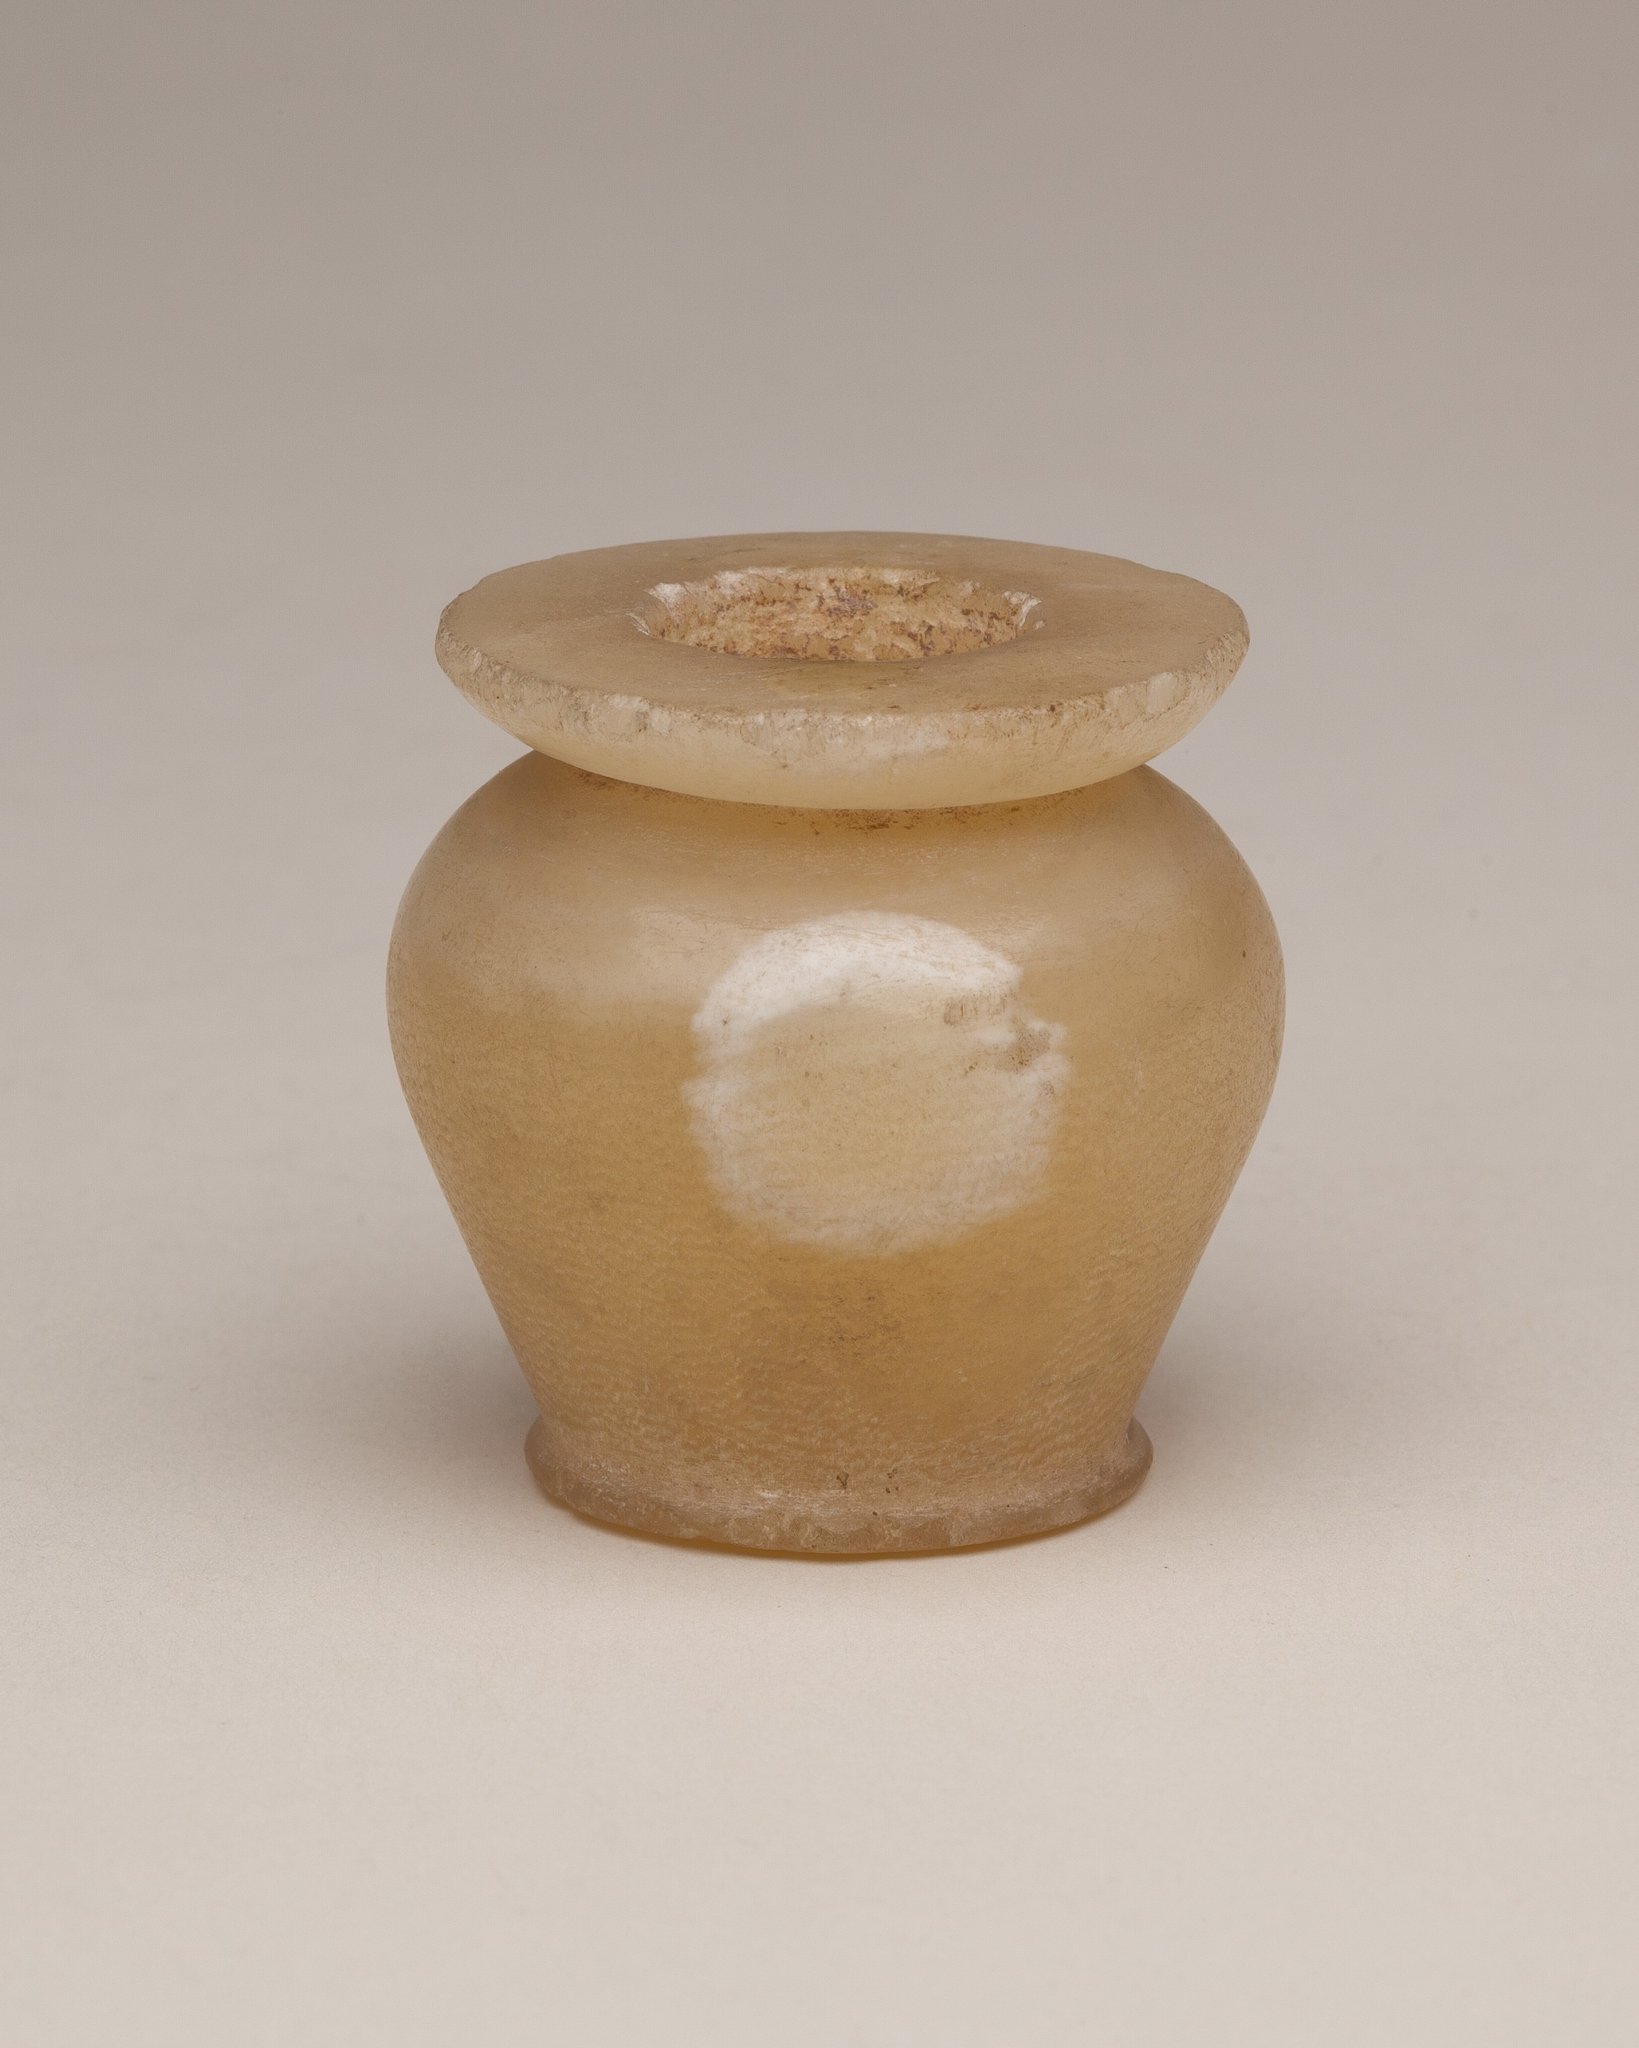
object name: kohl jar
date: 1981-1640 BCE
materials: stone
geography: egypt